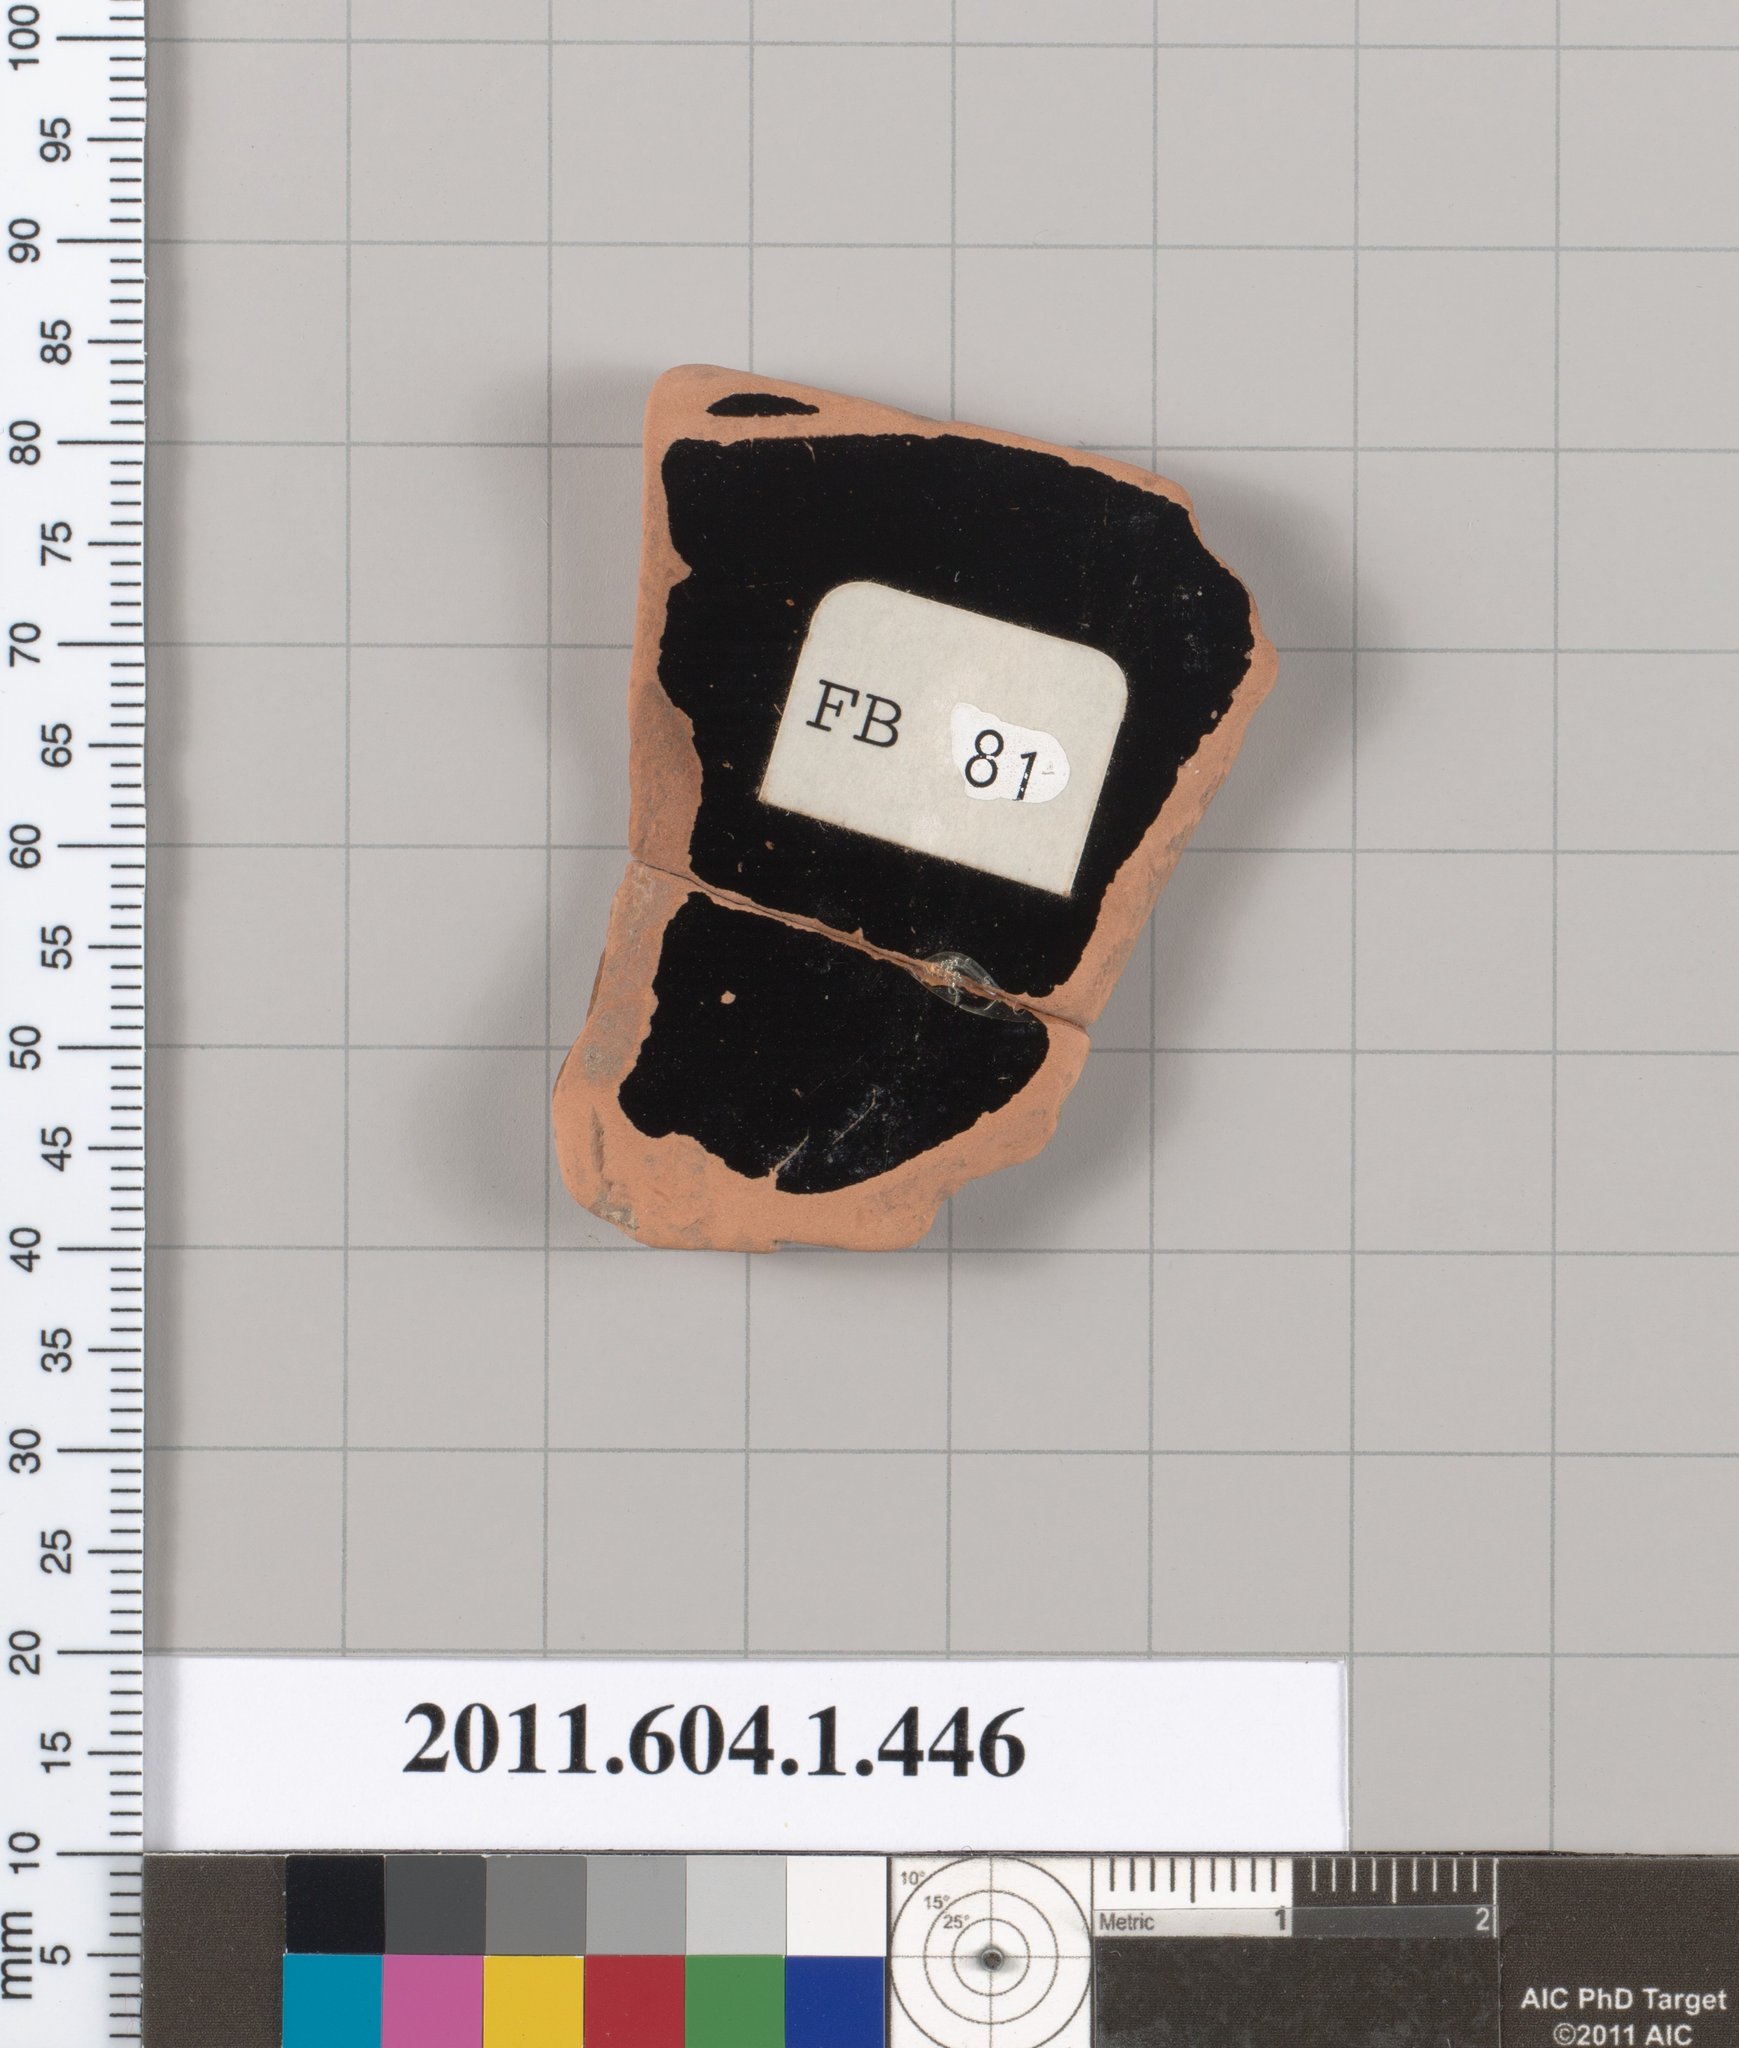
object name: kylix fragment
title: Terracotta fragment of a kylix (drinking cup)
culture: greek, attic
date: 475-451 BCE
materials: terracotta